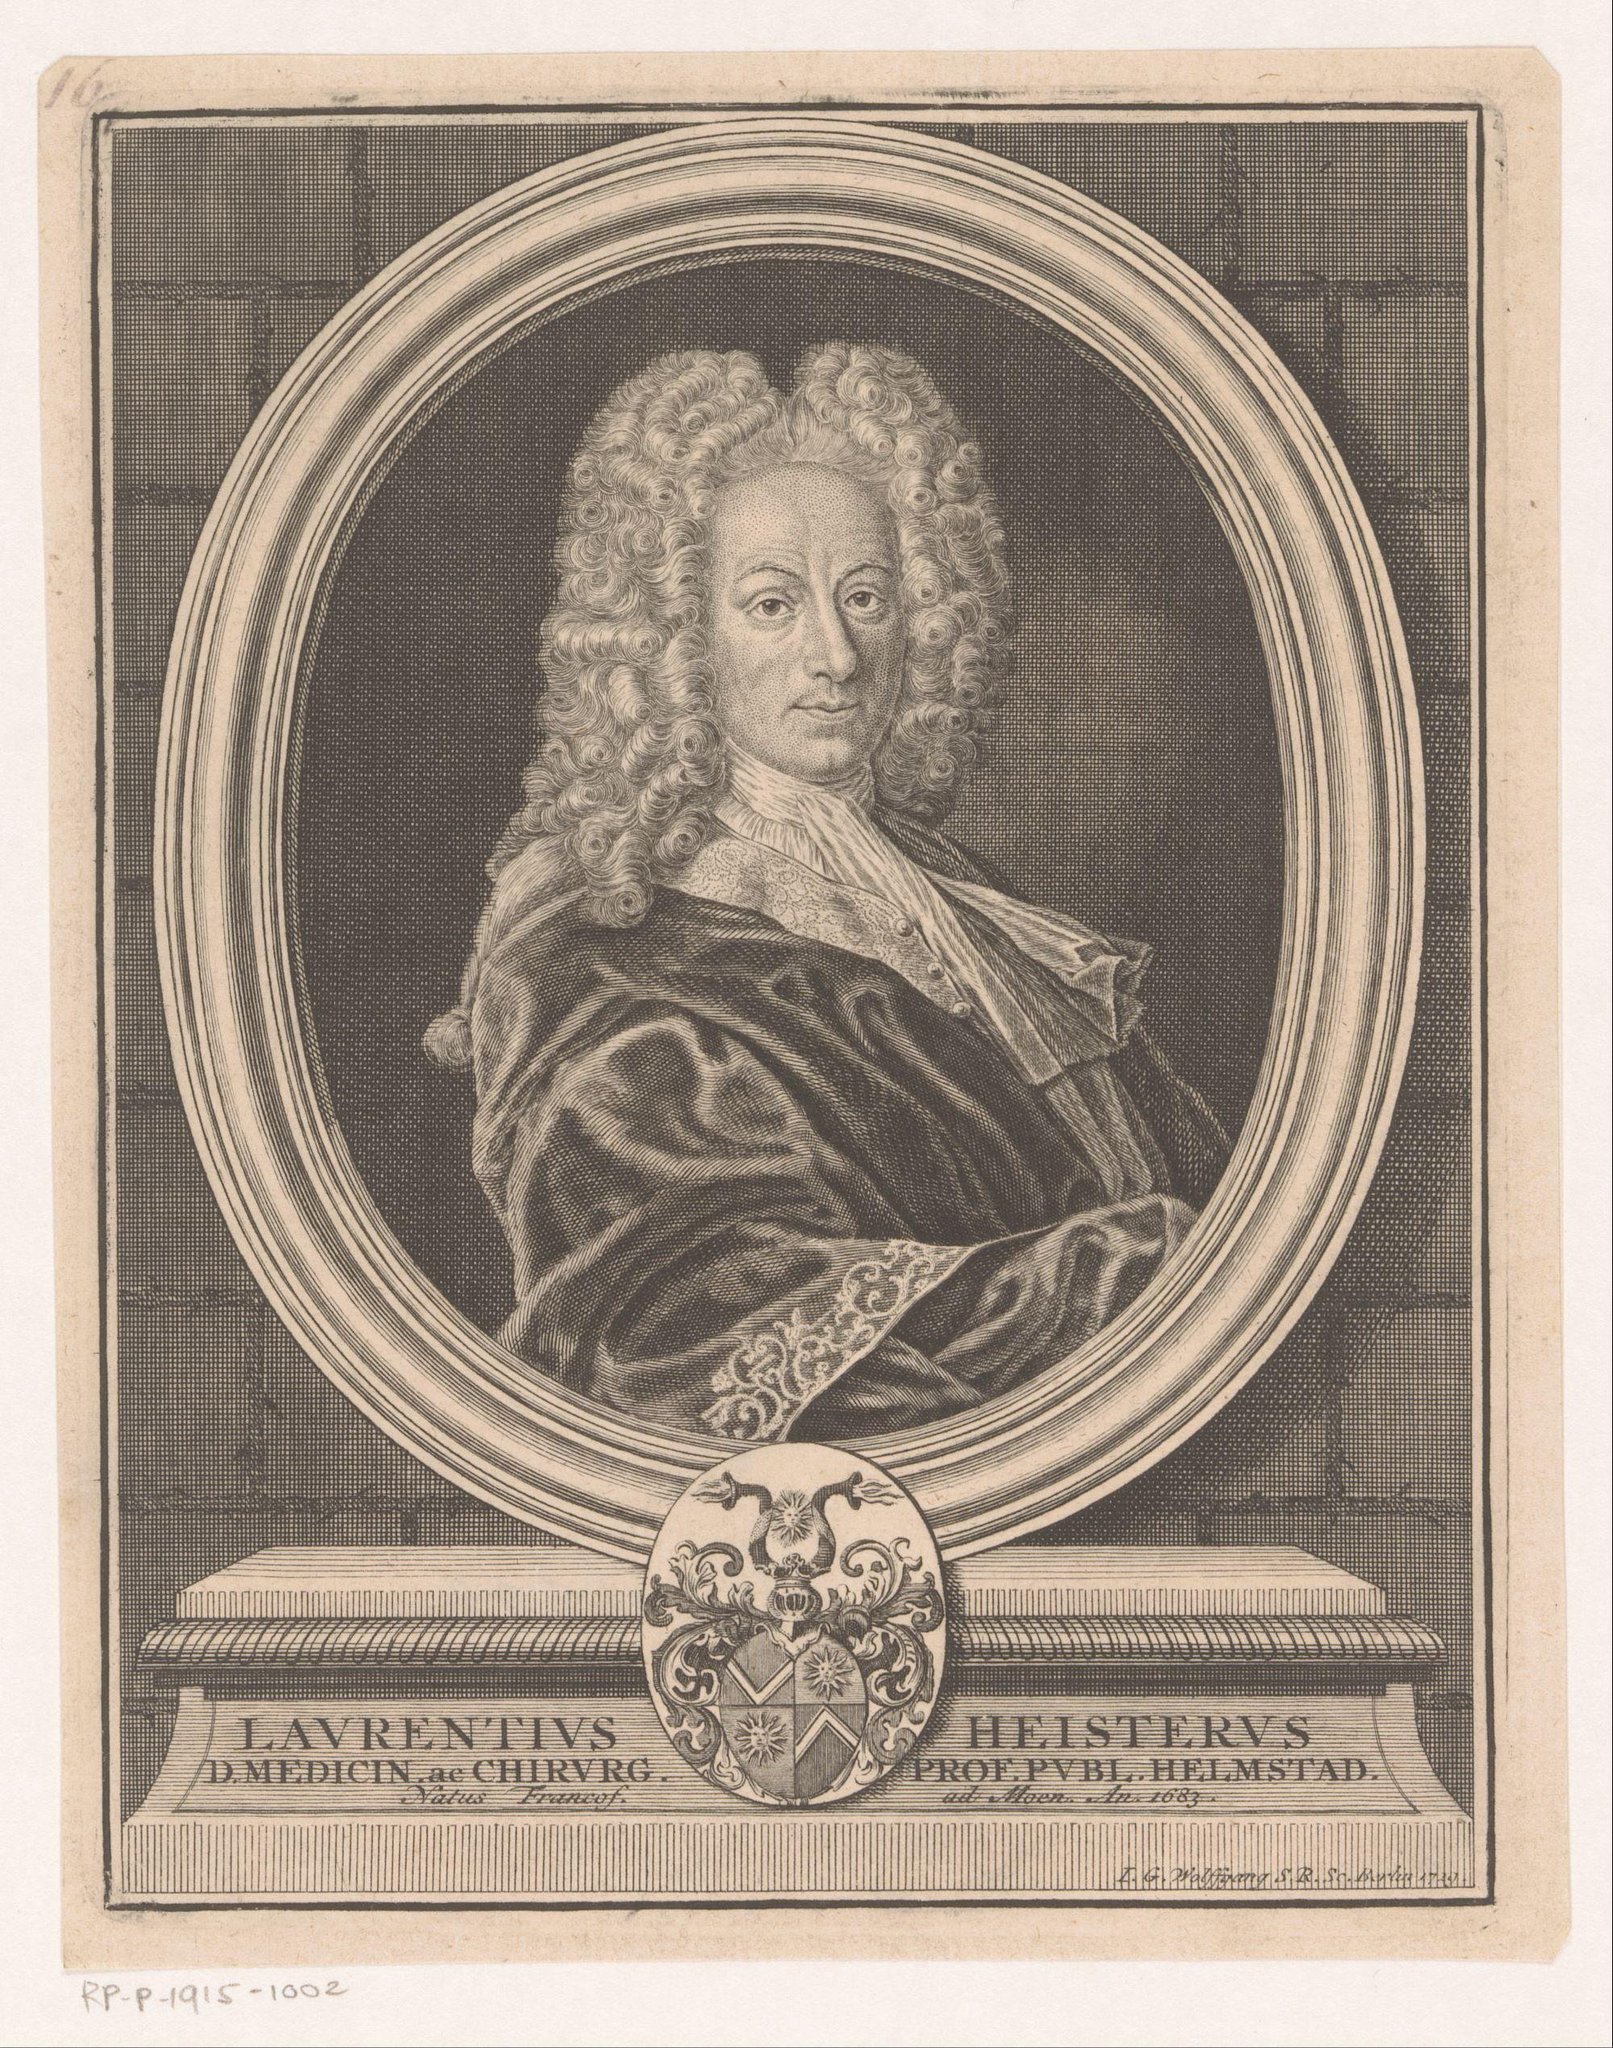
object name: print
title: Portret van Lorenz Heister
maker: johann georg wolfgang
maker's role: graveur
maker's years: 1662-1744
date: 1729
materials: paper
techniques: engraving, etching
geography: berlin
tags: historical persons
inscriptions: collector's mark: Lugt 2228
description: Prent gebruikt voor de publicatie: Heister, Lorenz. Institutiones chirurgicae. Amsterdam: Janssonius van Waesberge, 1739.